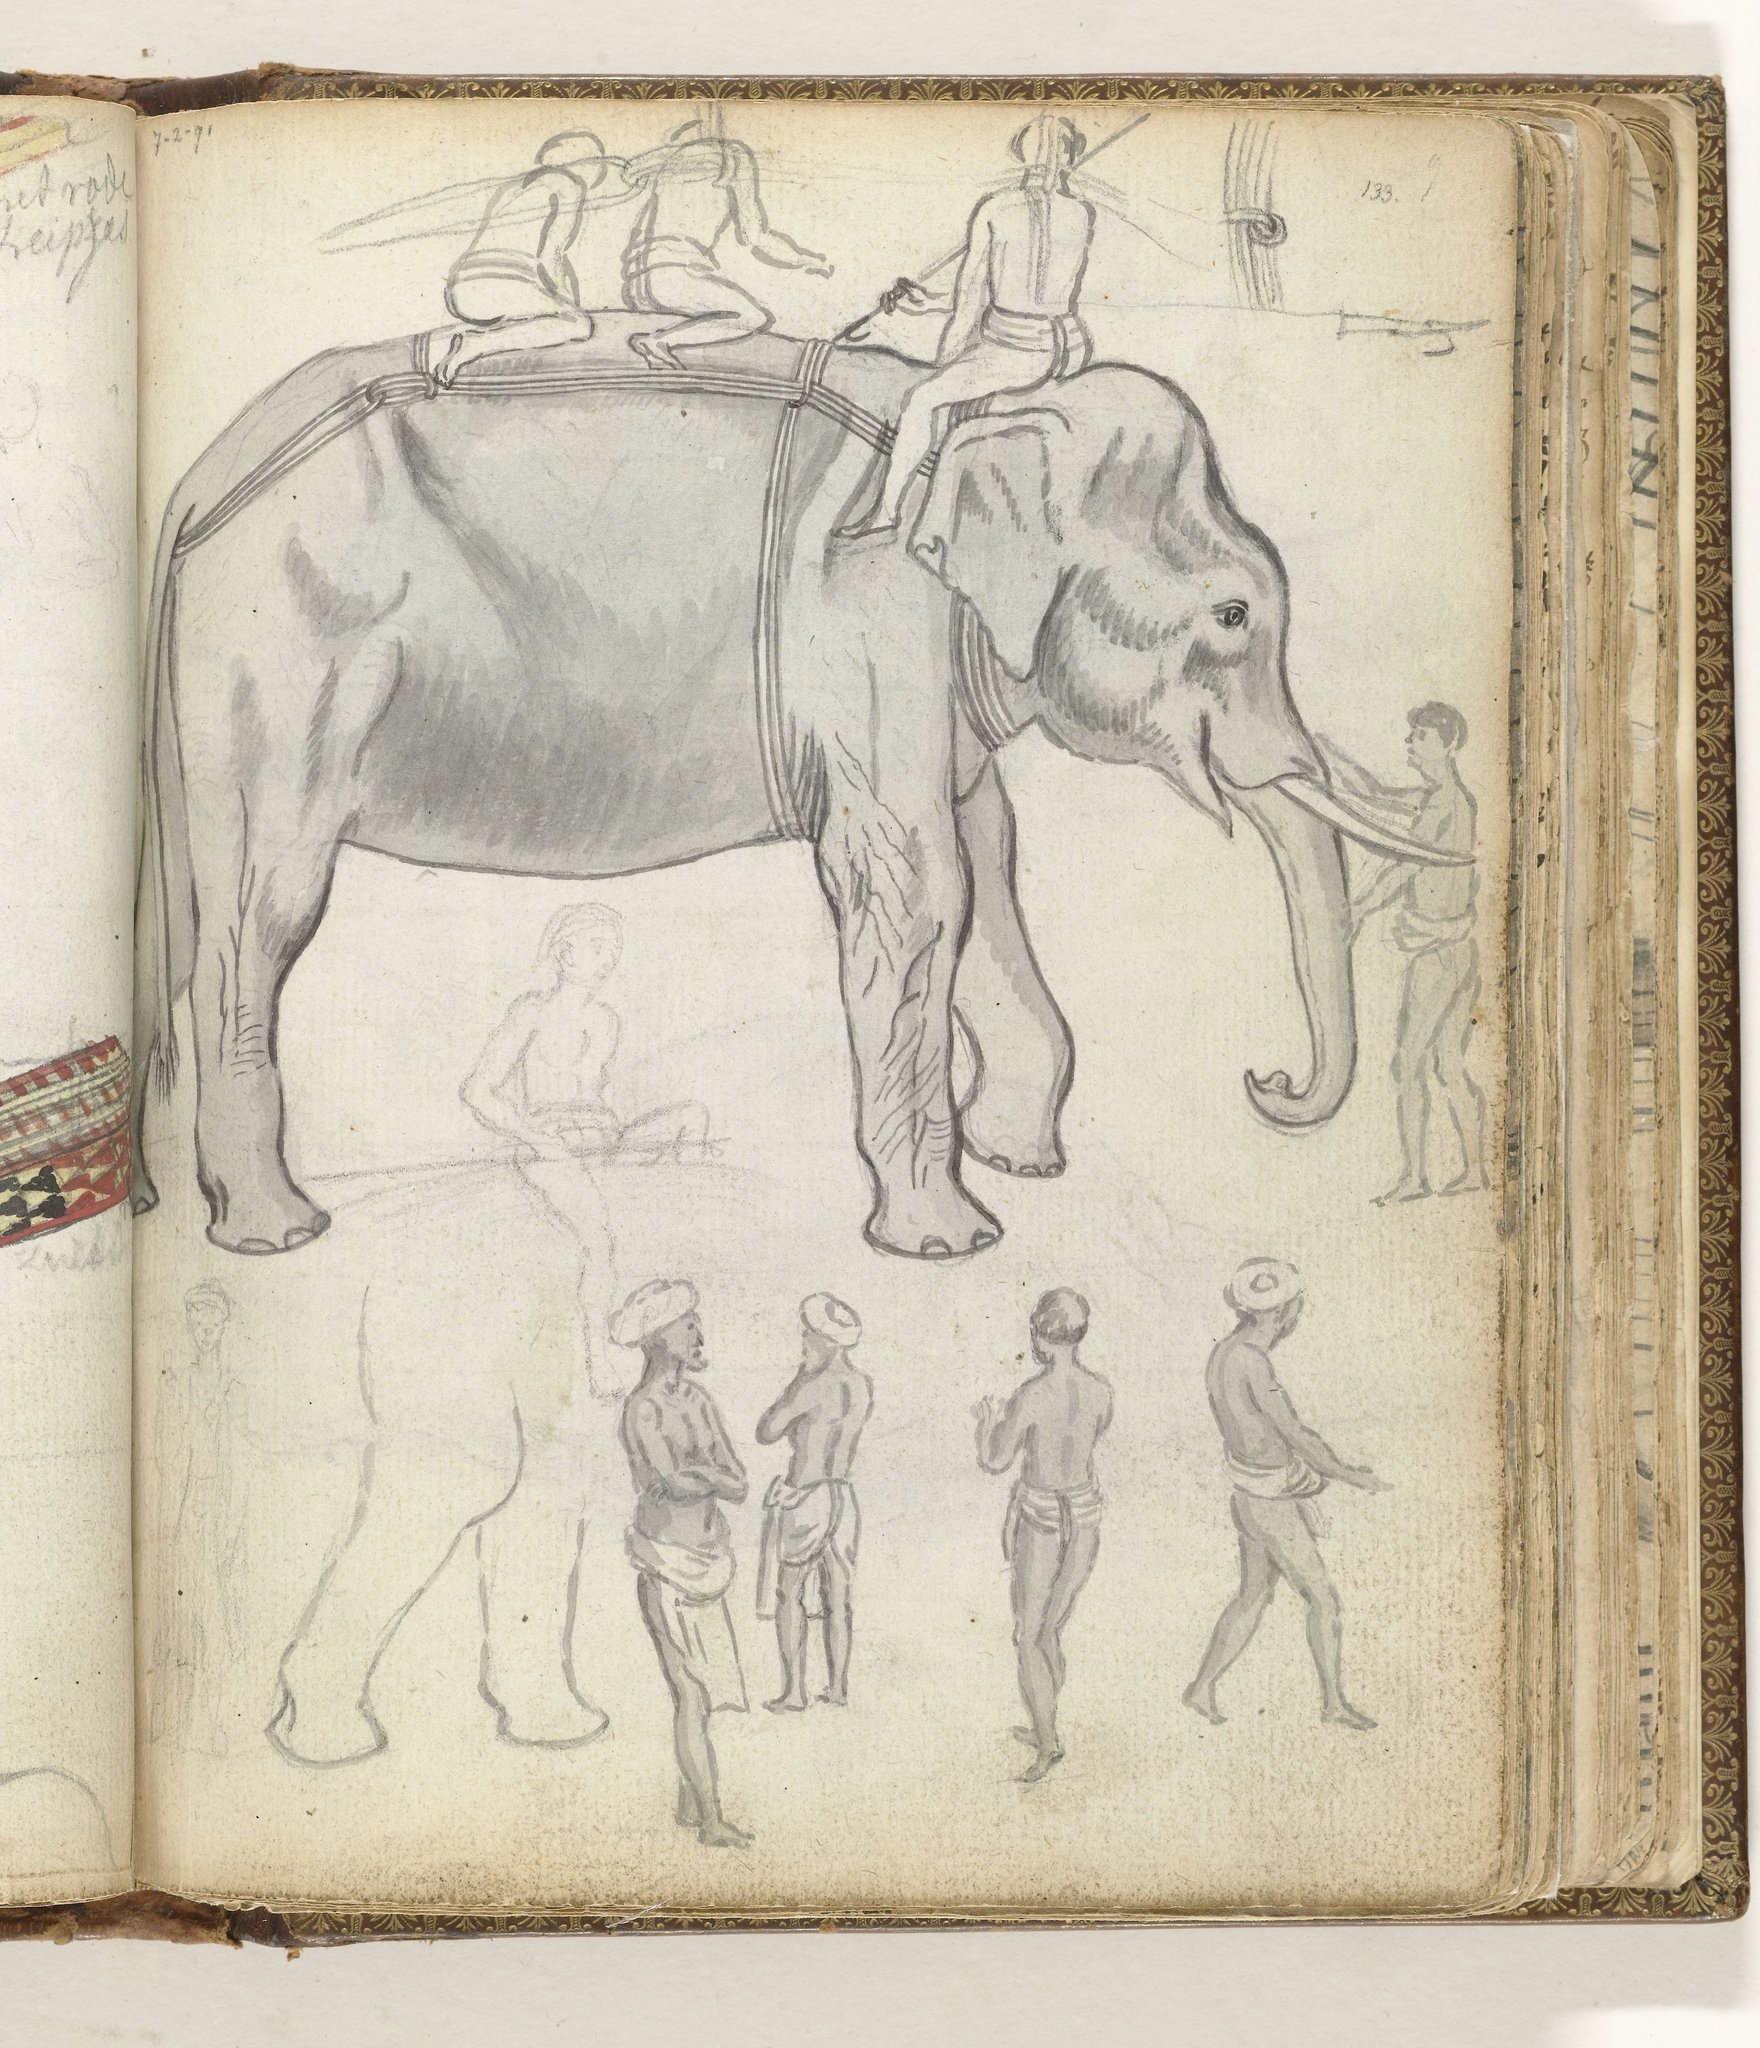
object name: drawing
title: Singalezen op olifant. Diverse Singalezen.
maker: jan brandes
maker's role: draughtsman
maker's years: 1743-1808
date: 1712-1785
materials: ink, paper, pencil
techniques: brush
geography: ja-ela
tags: trunked animals: elephant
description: Zwartwitte penseeltekening en potloodschetsen van een olifant met mensen op zijn rug. De Singalezen dragen lendedoeken en tulbanden. Onderdeel uit het schetsboek van Jan Brandes, dl. 2 (1808), p. 133.